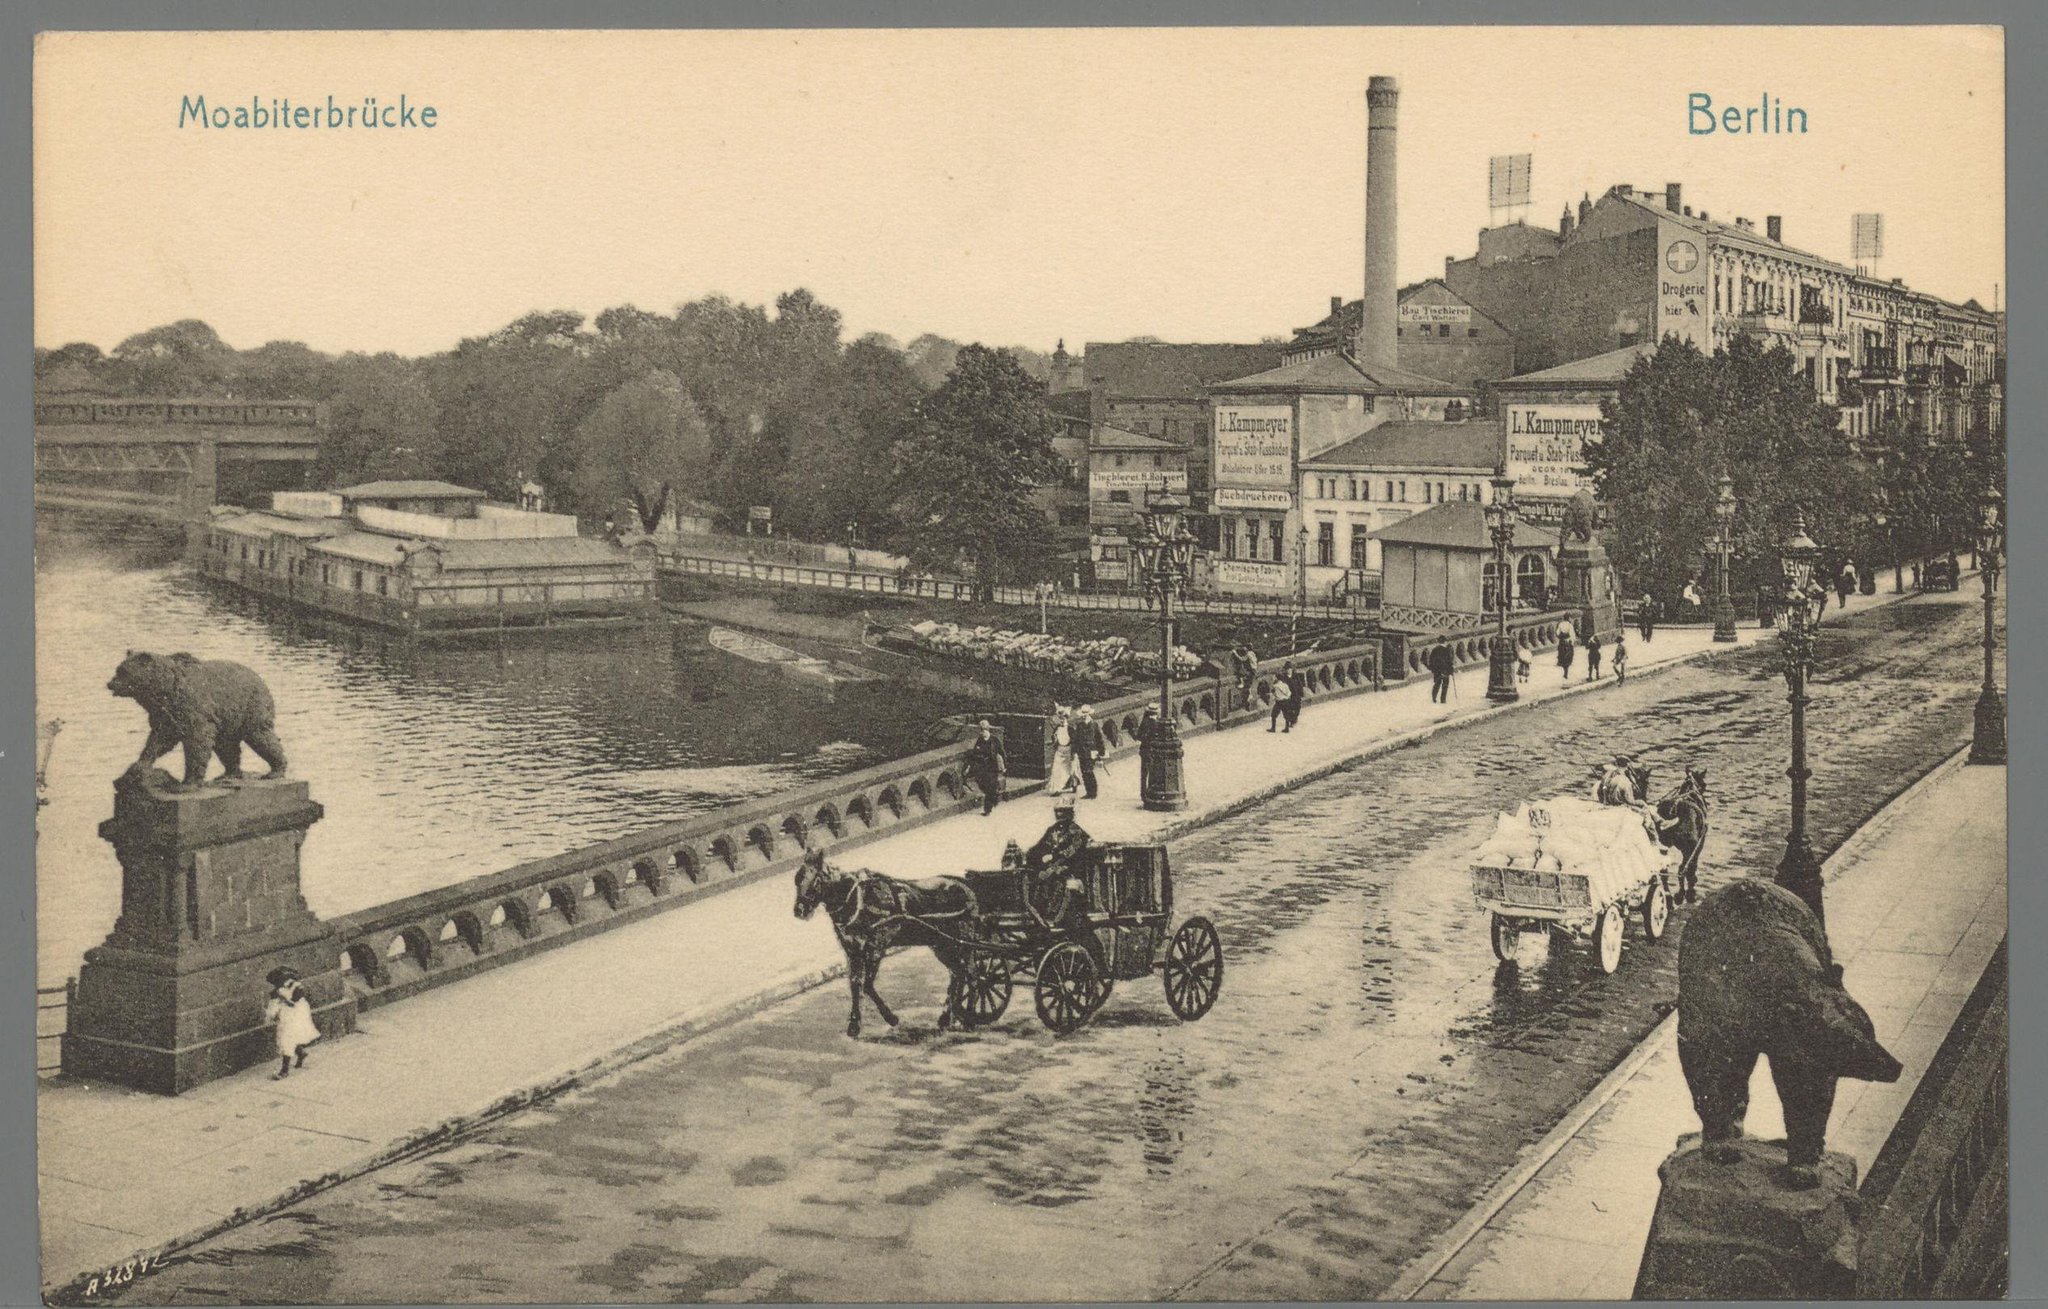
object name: photomechanical print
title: Moabiterbrücke. Berlin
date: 1906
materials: cardboard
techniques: photograph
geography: berlin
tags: canals, waters (in city), bridge in city across river, canal, etc., berlin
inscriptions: stamp: ‘5’